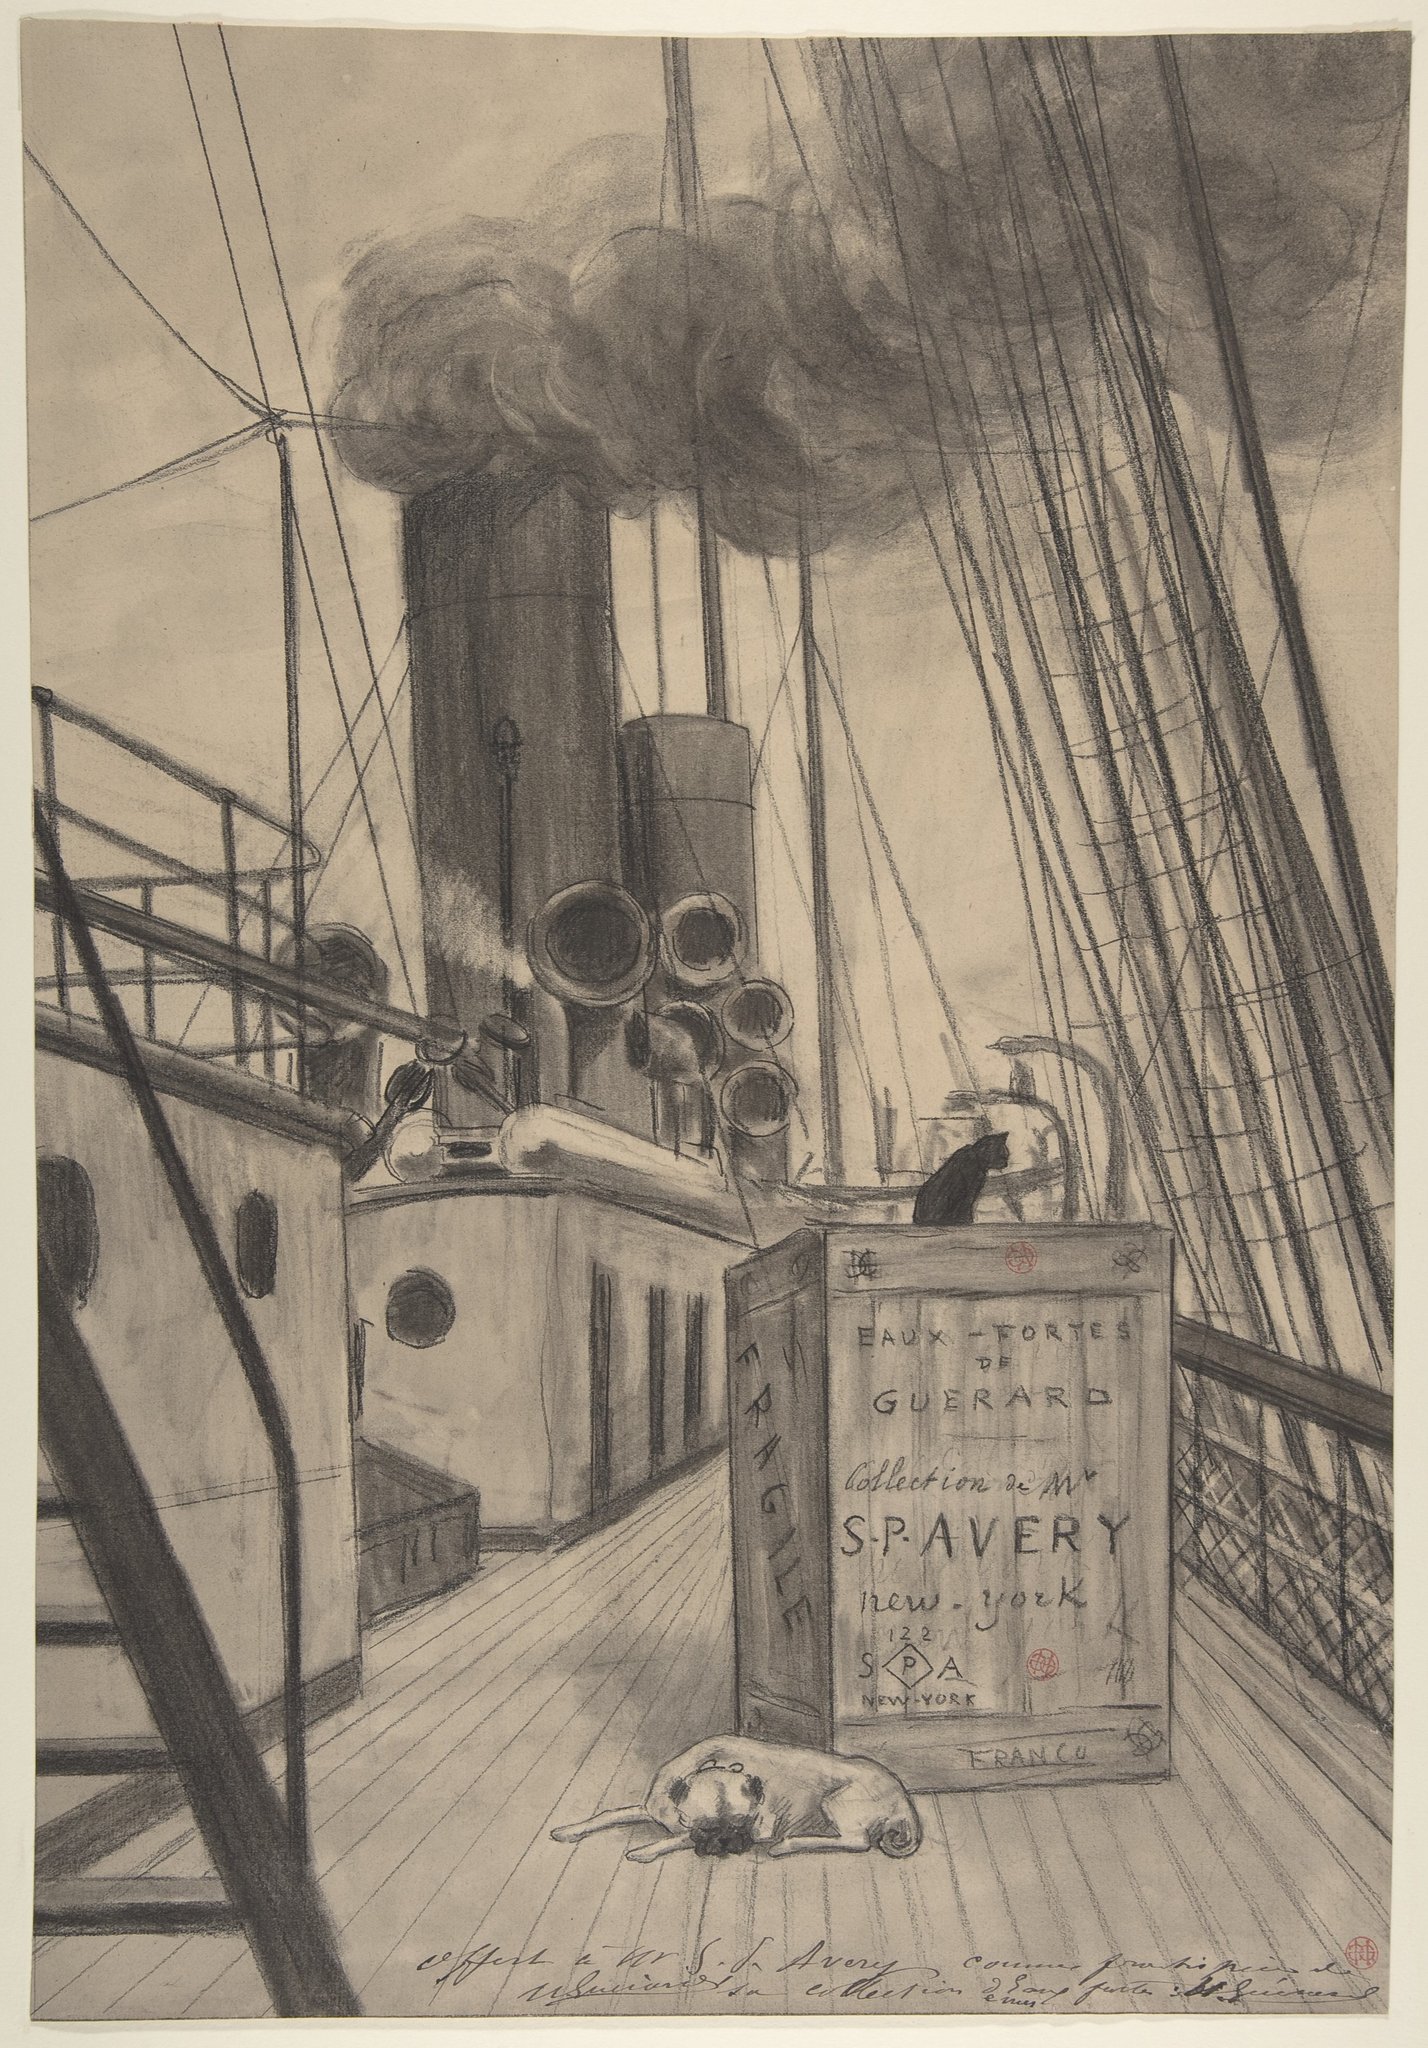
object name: drawing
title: Frontispiece to "Eaux-fortes de Guérard, Collection de Mr. S. P. [Samuel Putnam] Avery, New York"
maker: henri-charles guérard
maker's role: artist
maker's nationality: french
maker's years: 1846-1897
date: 1867-1900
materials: chalk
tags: dogs,ships